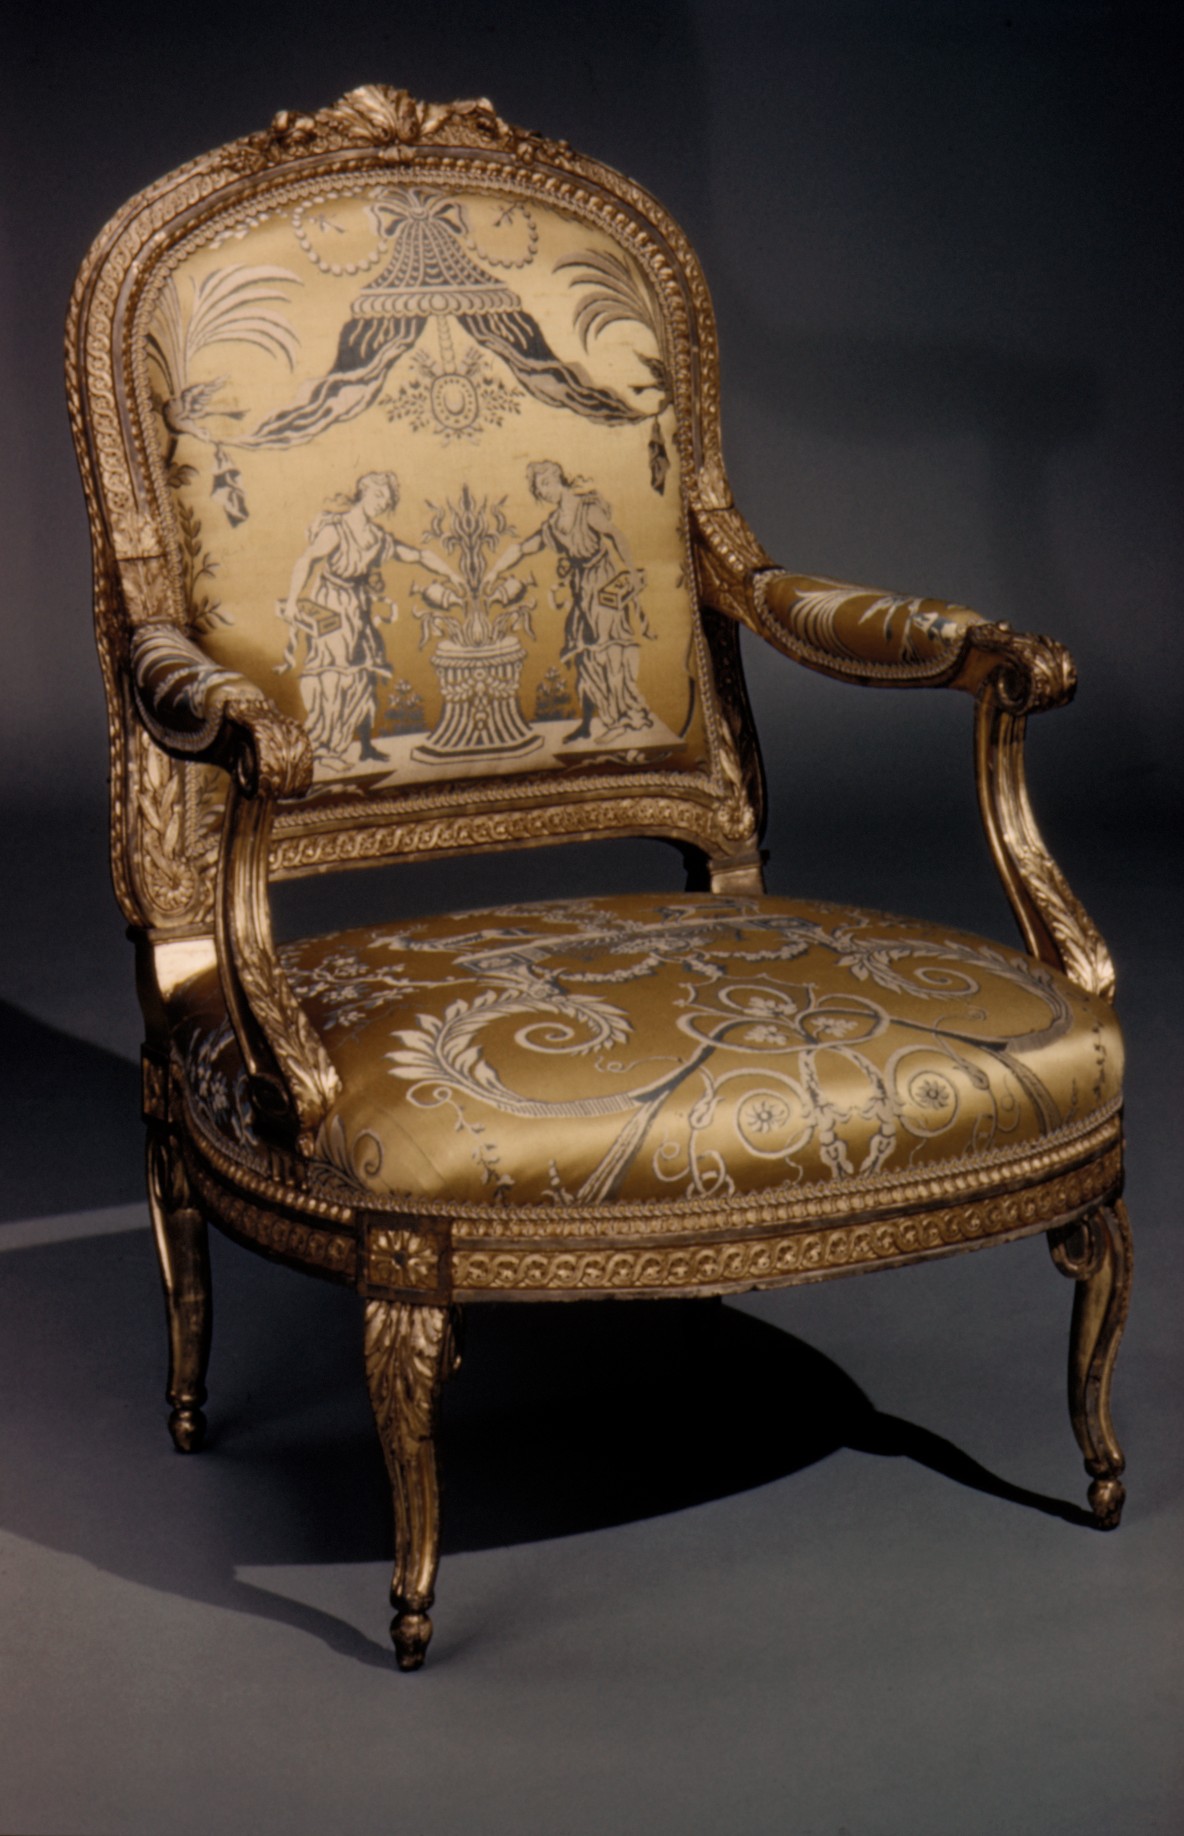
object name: armchair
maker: georges jacob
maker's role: maker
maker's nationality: french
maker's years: 1739-1814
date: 1770-1780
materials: gold, wood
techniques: carving, gilding, lampas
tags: women